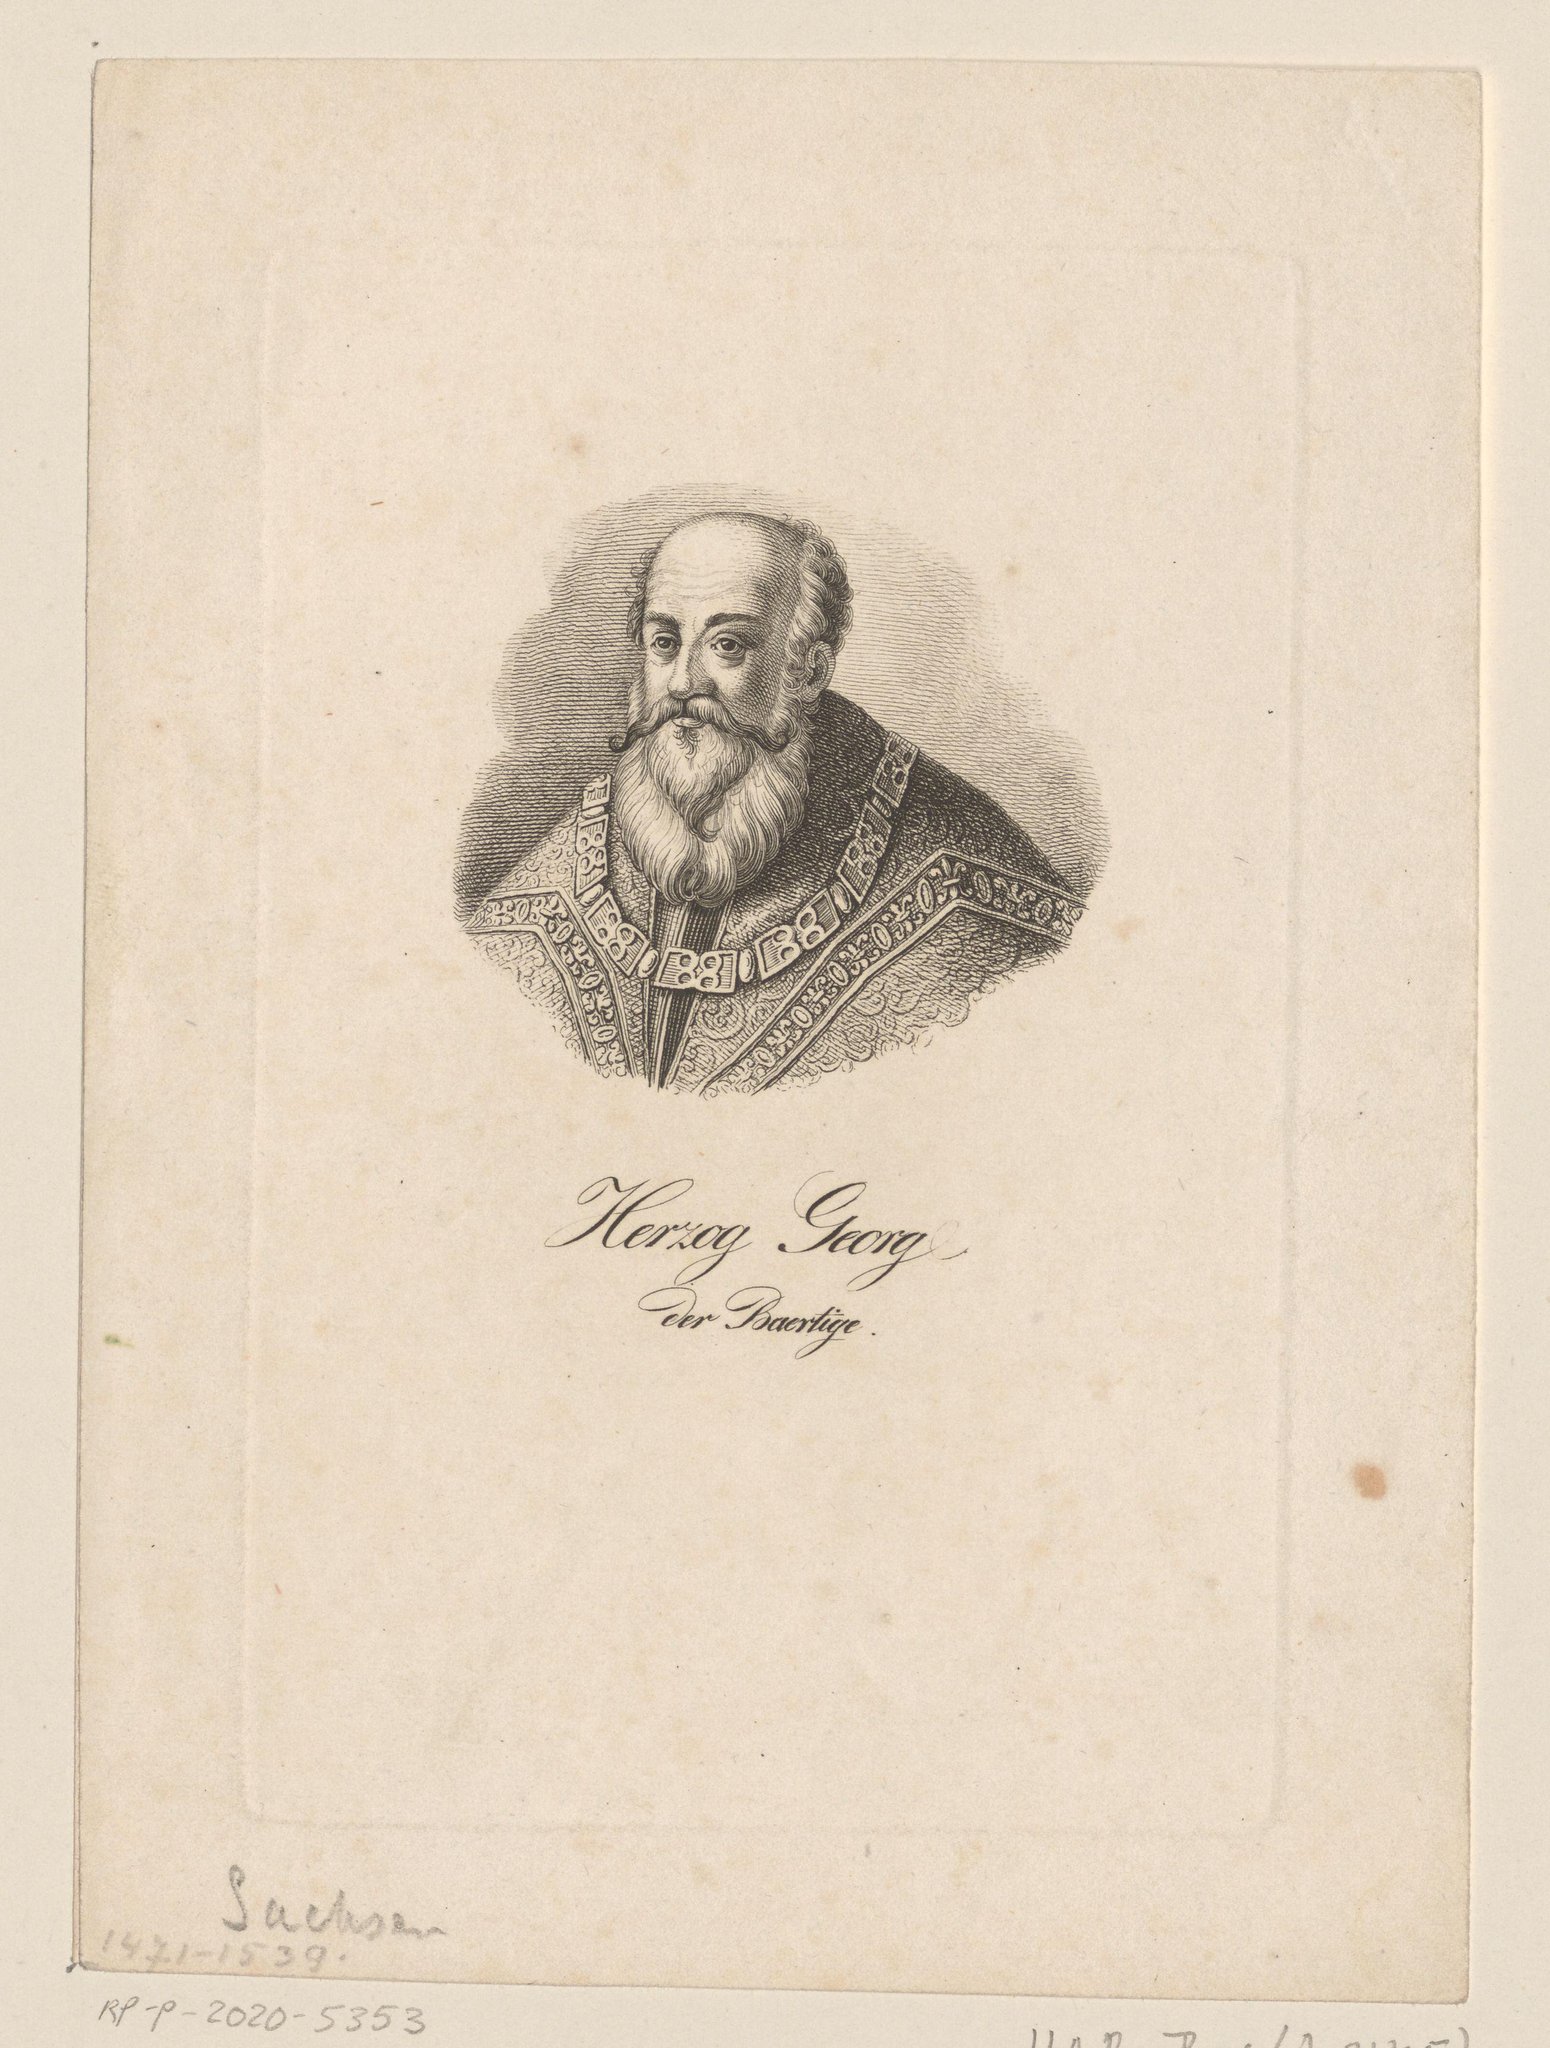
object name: print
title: Portret van George, hertog van Saksen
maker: Anonymous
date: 1750-1850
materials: paper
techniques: engraving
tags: historical persons